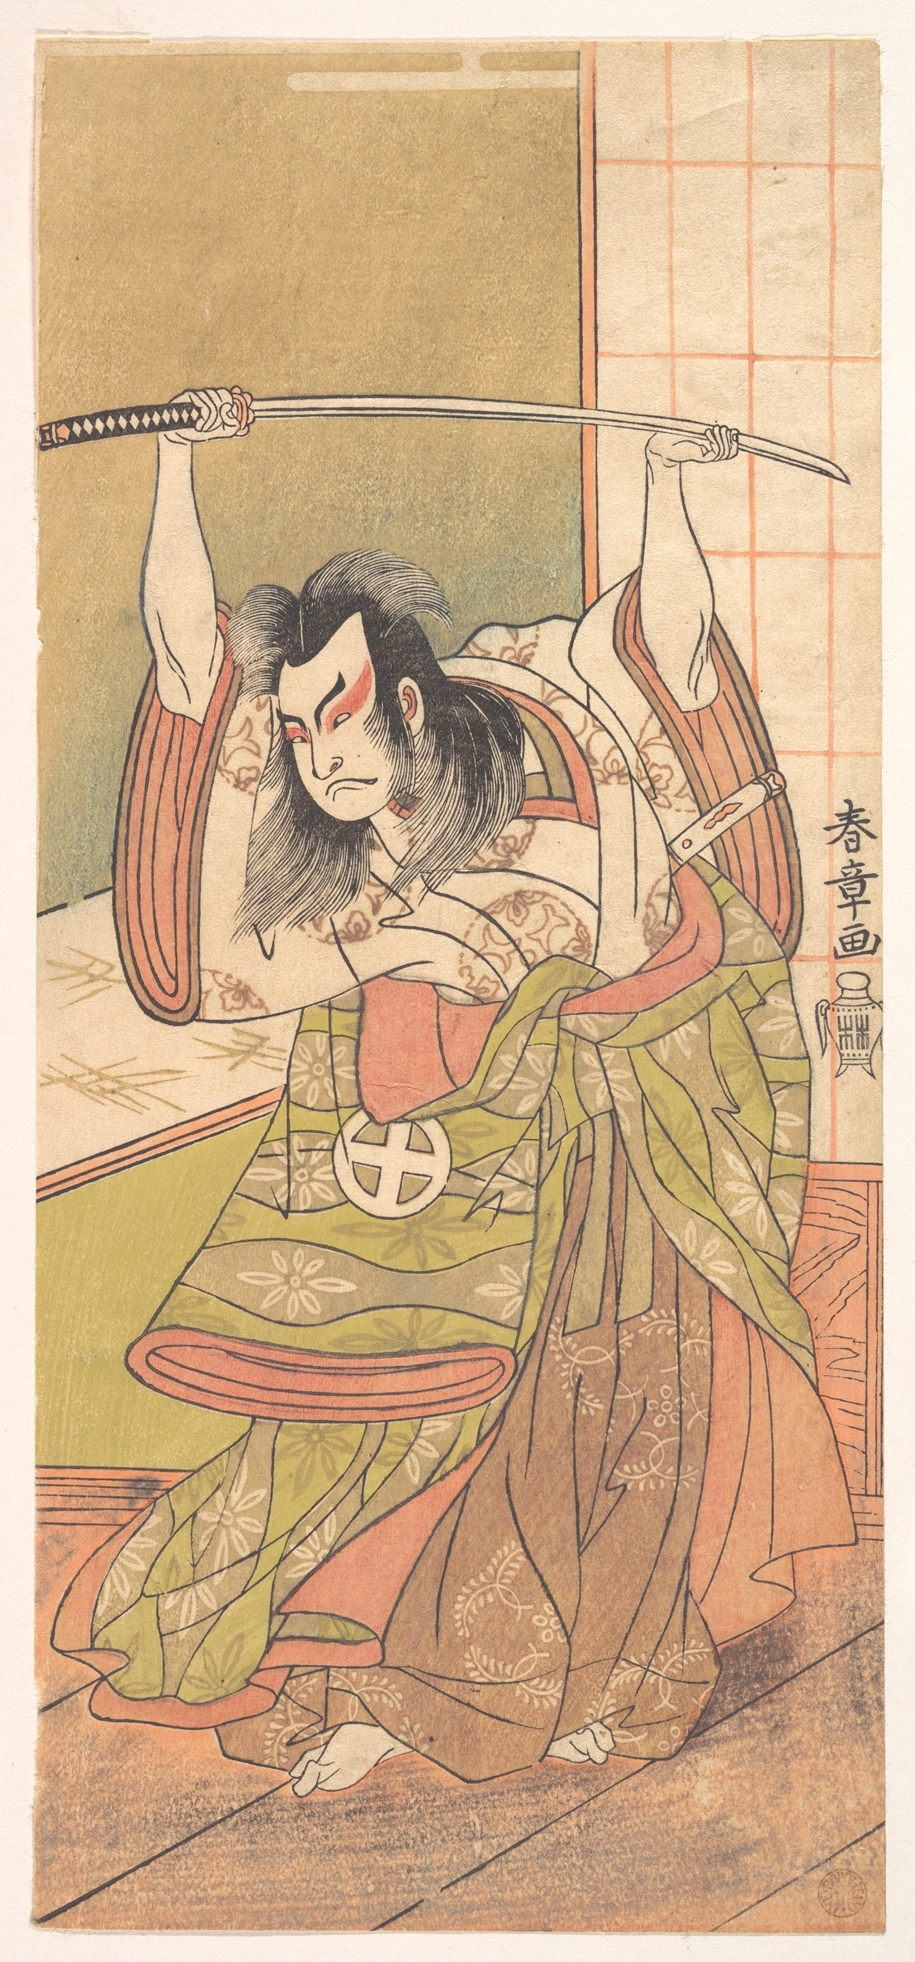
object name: woodblock print nishiki e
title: The Third Otani Hiroji as a Daimyo Standing on the Engawa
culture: japanese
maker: katsukawa shunshō 勝川春章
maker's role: artist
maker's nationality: japanese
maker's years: 1726-1792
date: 1771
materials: ink, paper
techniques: nishiki e, woodblock print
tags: swords,men,actors